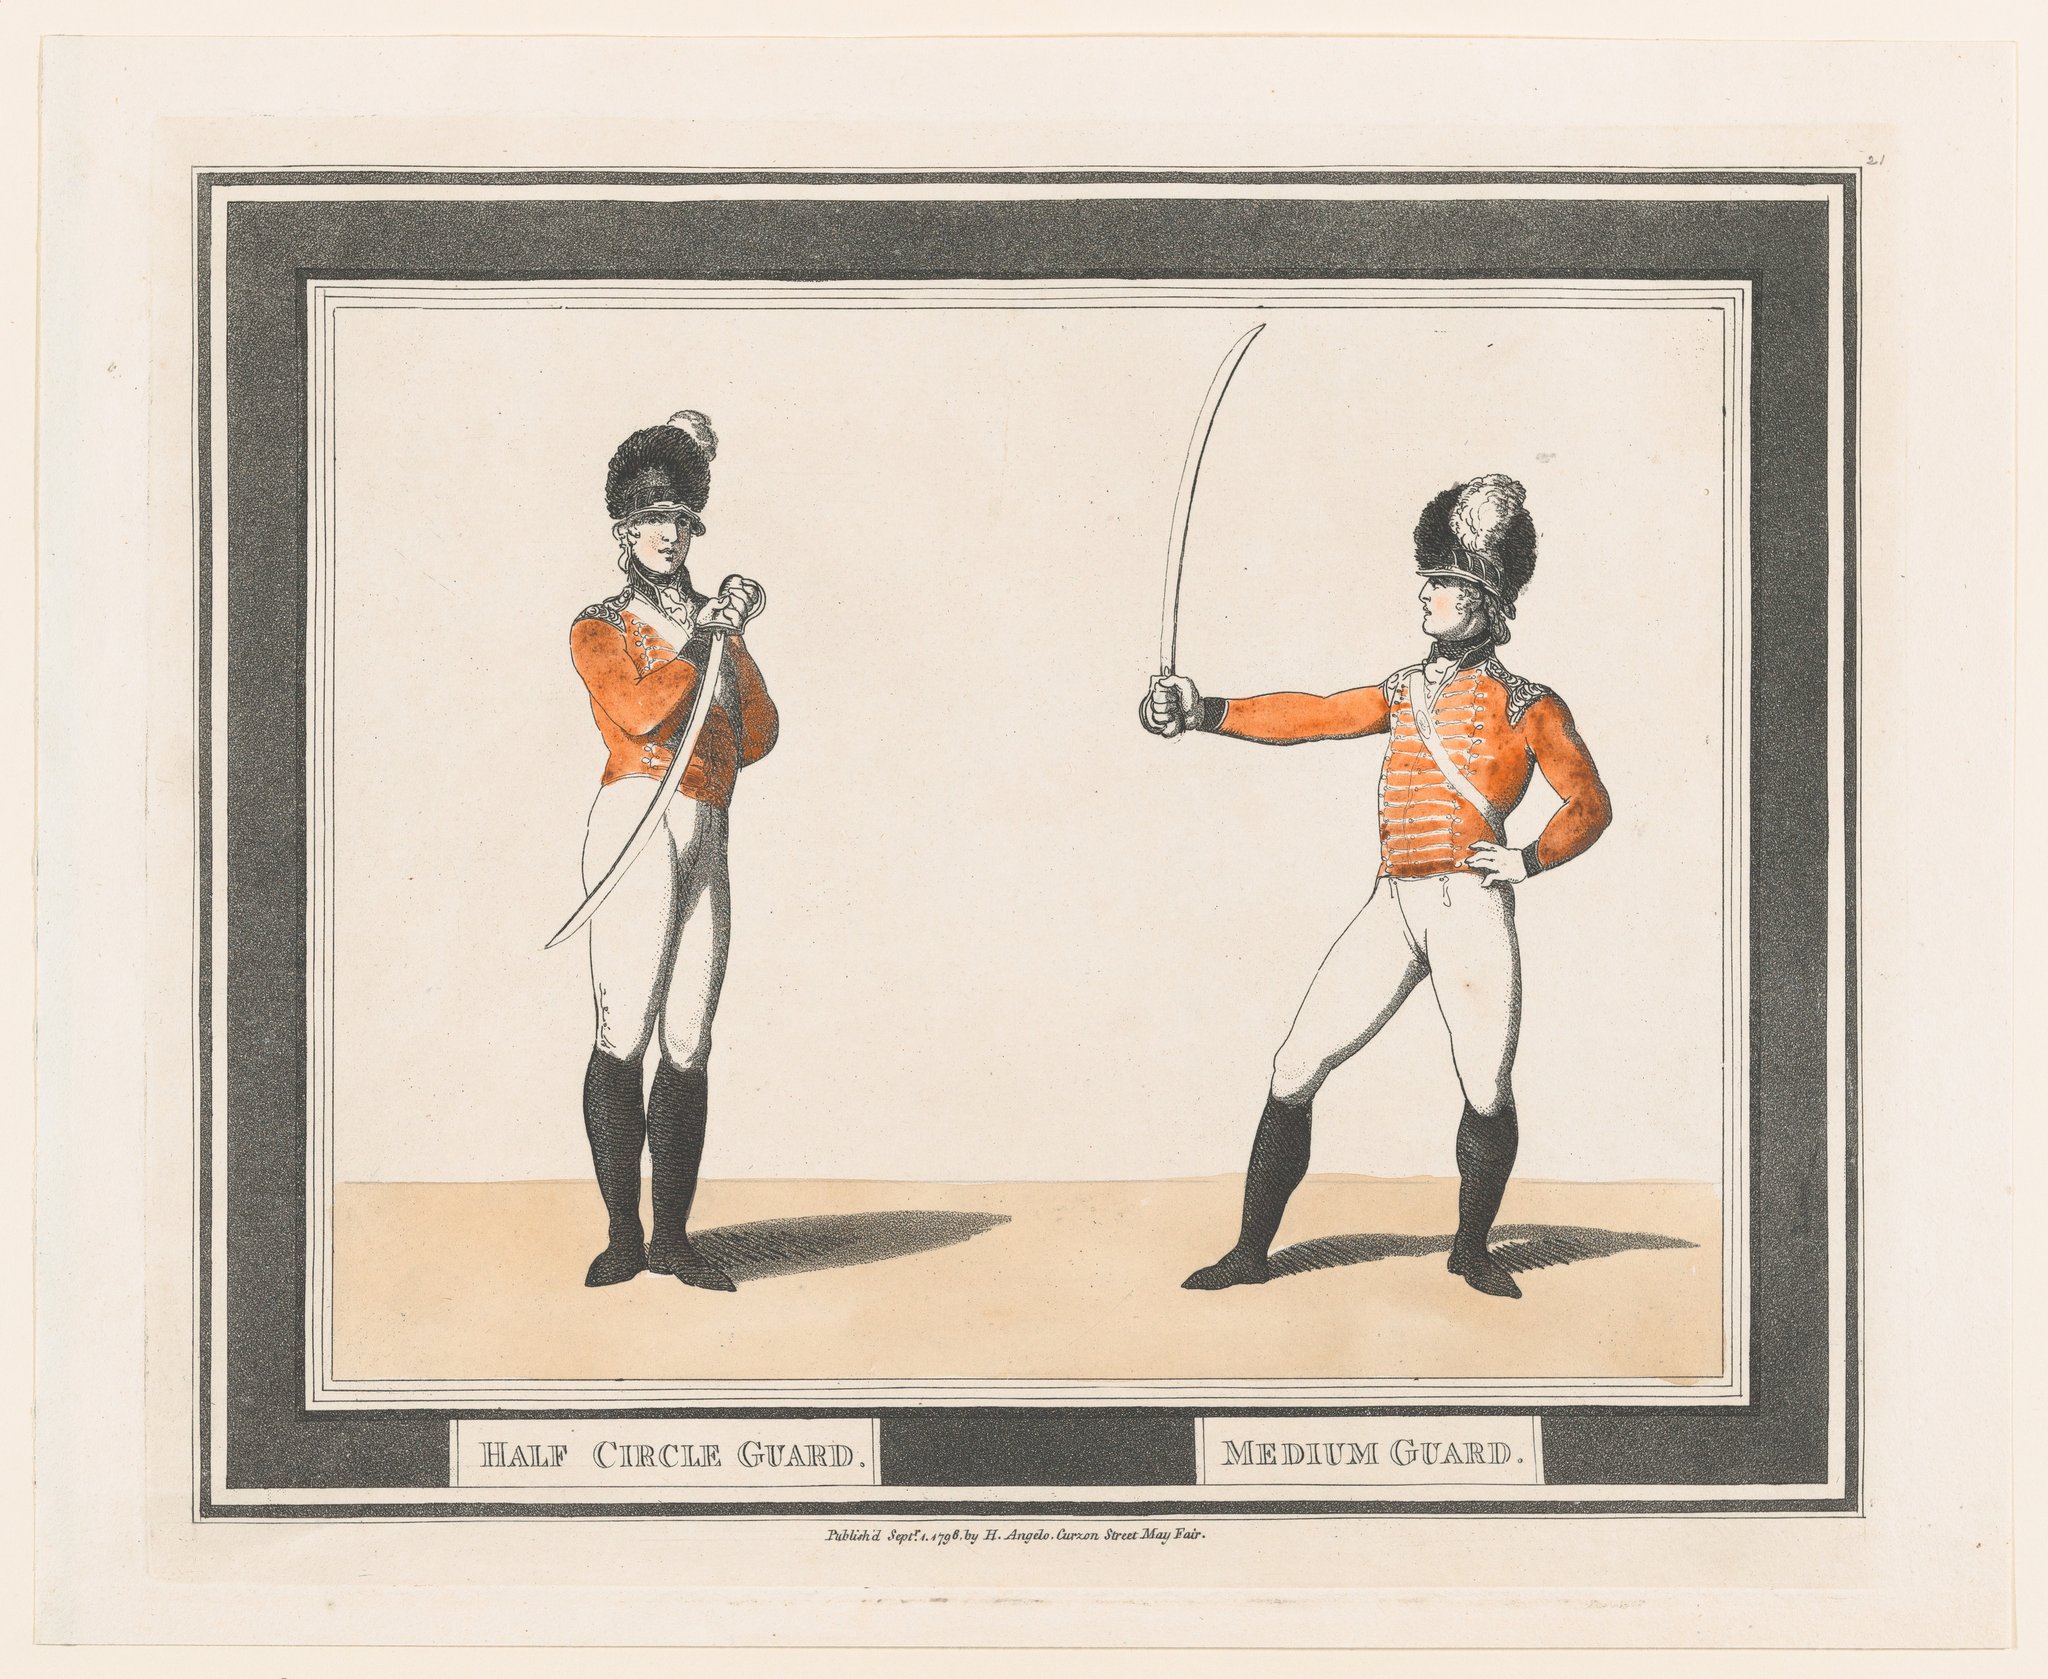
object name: print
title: Half Circle Guard, Medium Guard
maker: thomas rowlandson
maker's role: artist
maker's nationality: british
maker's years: 1757-1827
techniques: aquatint, etching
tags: swords,men